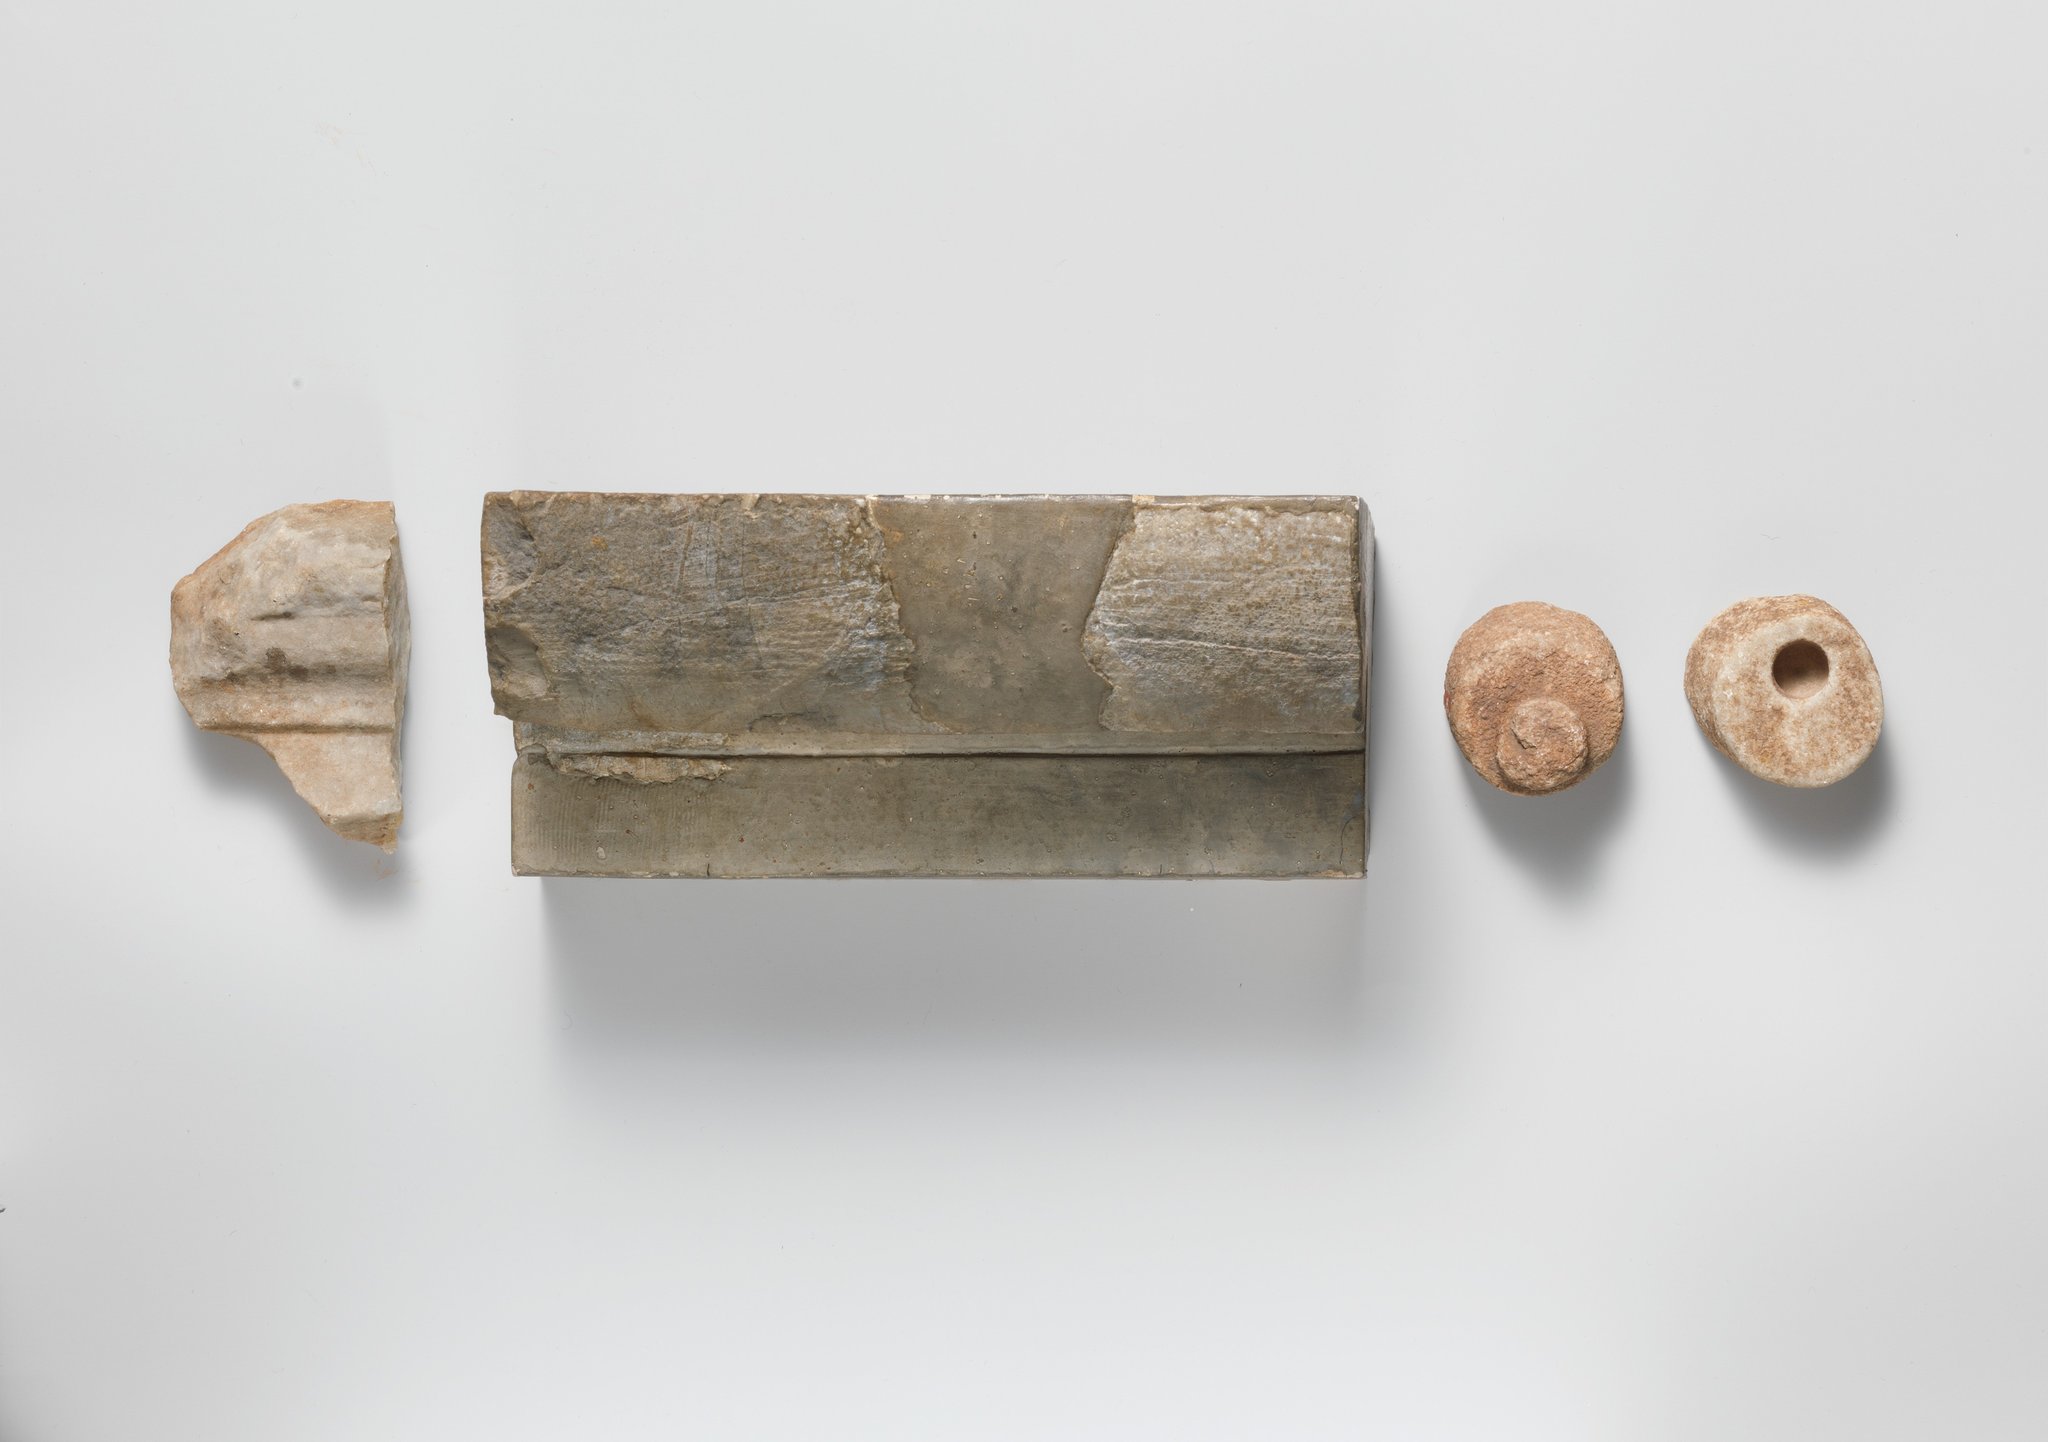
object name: gutti, two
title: Two gutti from a group of fragments from the Temple of Apollo at Phigaleia (Bassae)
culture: greek, arcadian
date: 500-401 BCE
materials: marble